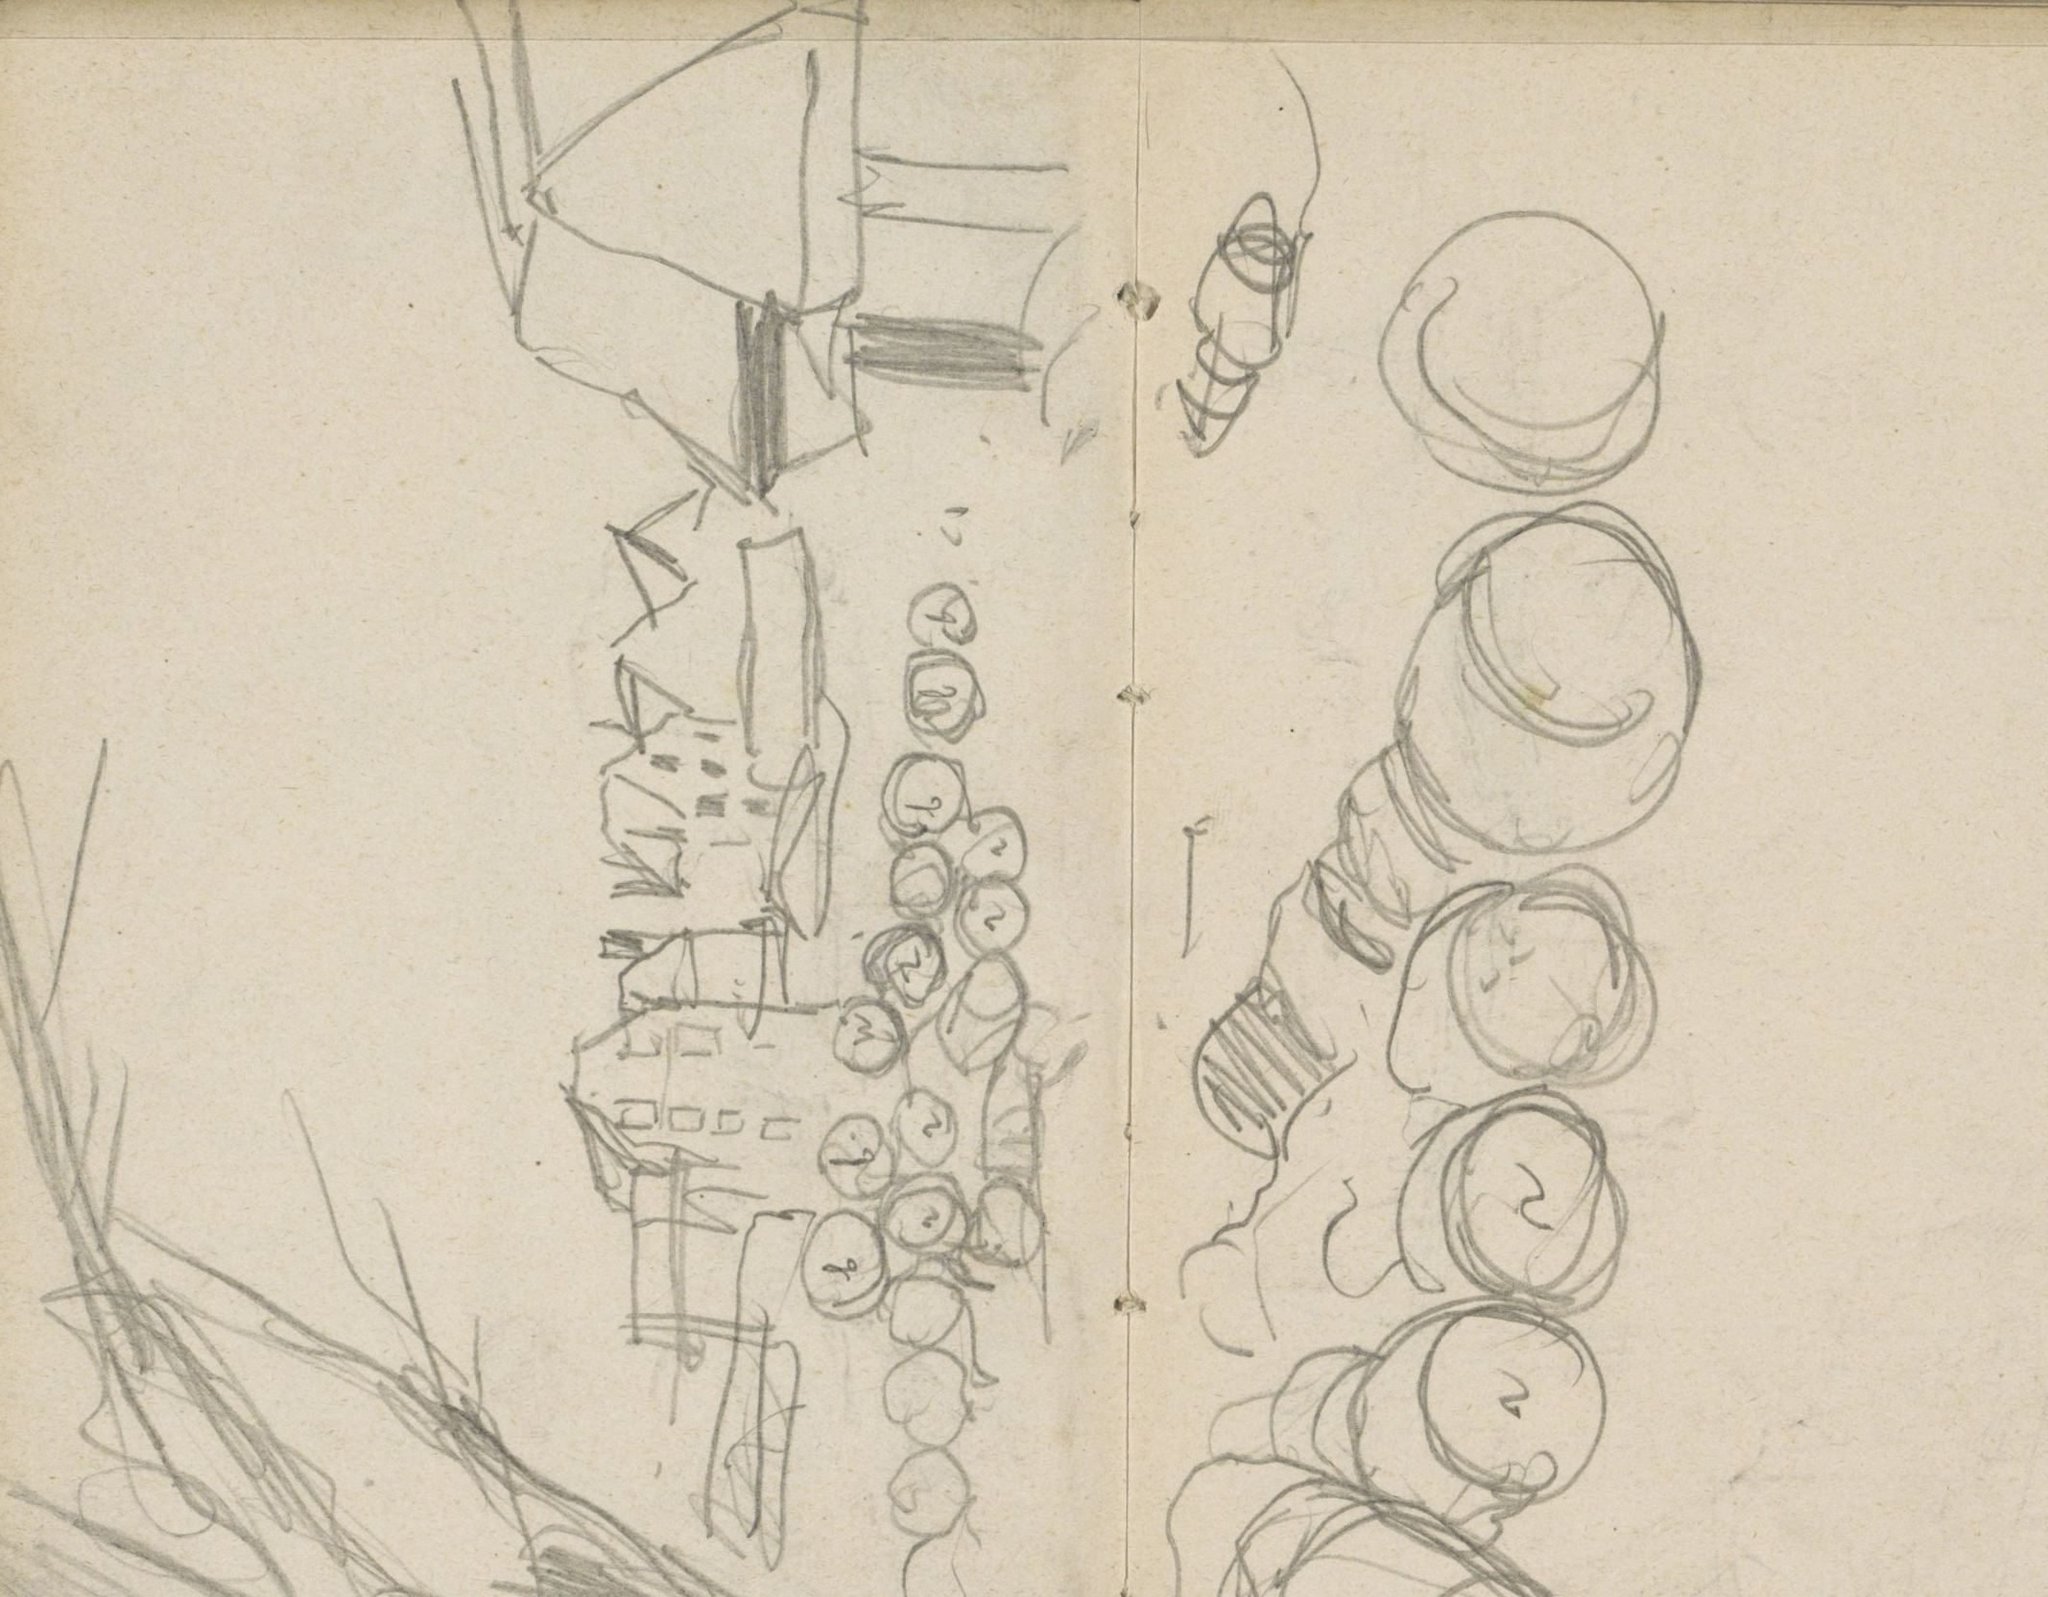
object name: sketchbook leaf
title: Gezicht op de Nieuwe Teertuinen en Prinseneiland te Amsterdam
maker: george hendrik breitner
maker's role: draughtsman, painter, print maker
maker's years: 1857-1923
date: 1903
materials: paper, pencil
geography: amsterdam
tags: urban housing, containers, industrial structures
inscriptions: kleurnotitie, handgeschreven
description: Vooraan de Nieuwe Teertuinen met teertonnen en rechts de kraan van de teerkokerij. Op de achtergrond Prinseneiland. Pagina 7 en pagina 8 uit een schetsboek met 46 bladen.